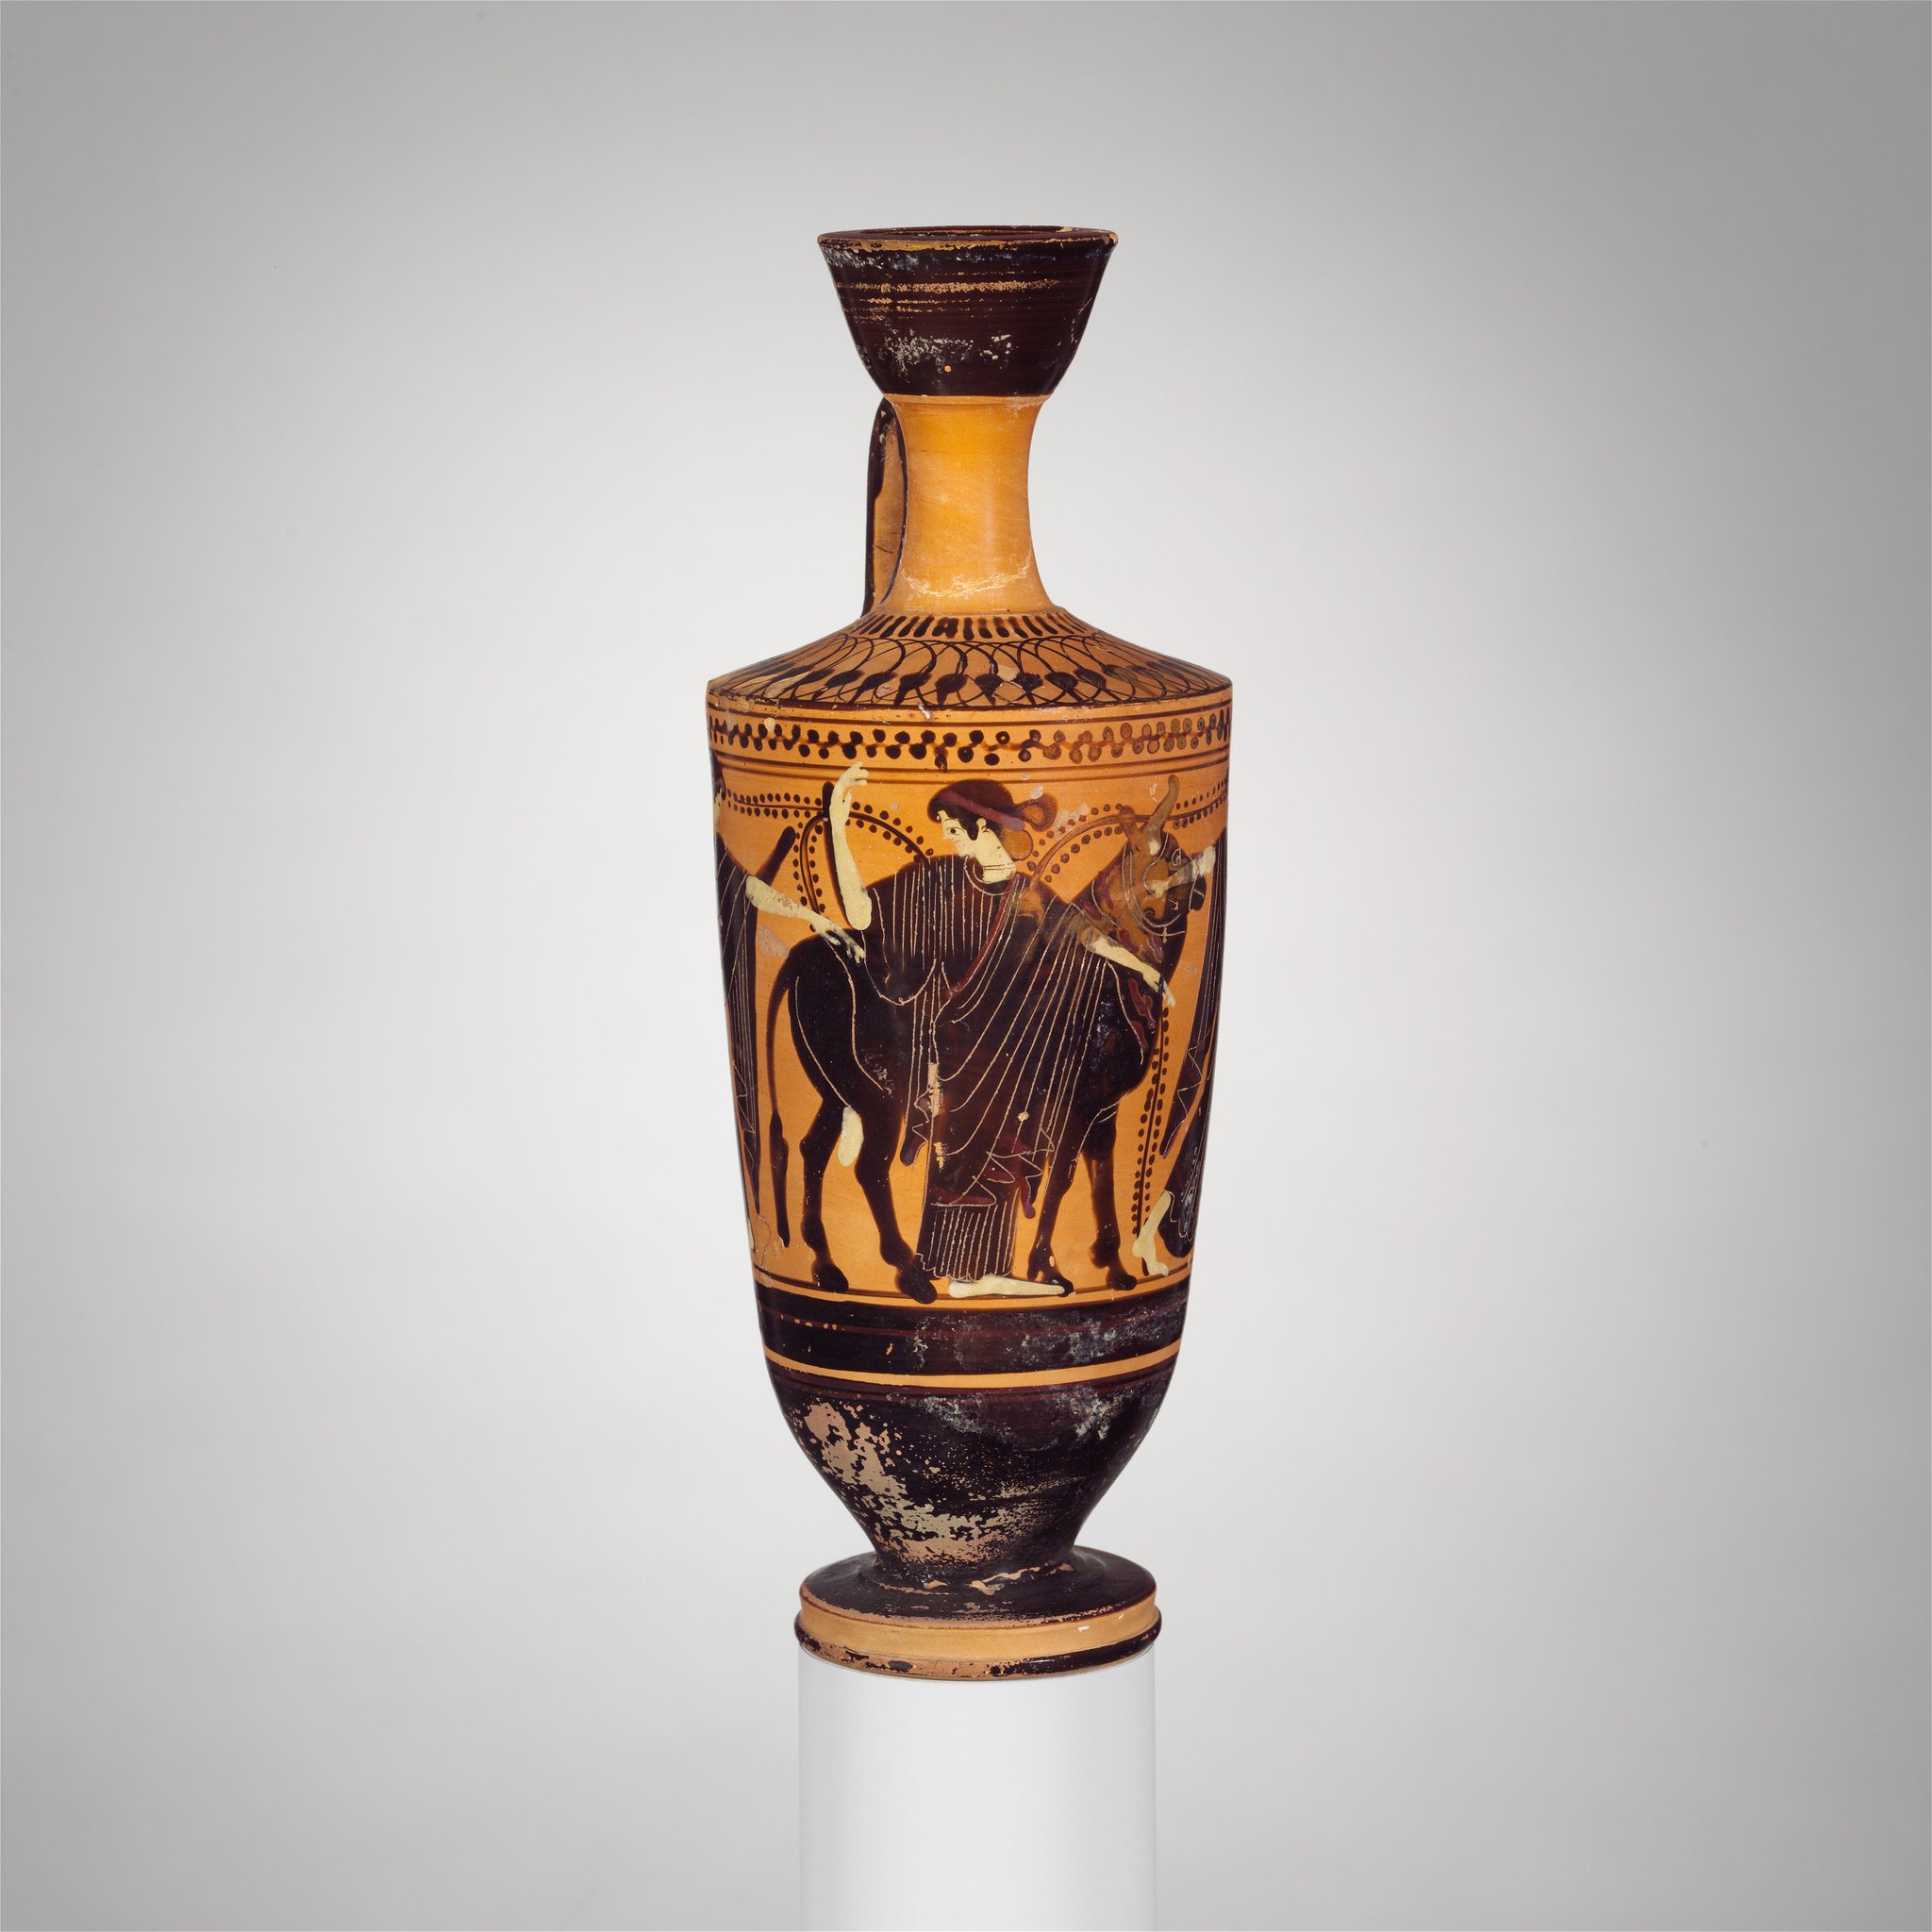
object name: lekythos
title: Terracotta lekythos (oil flask)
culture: greek, attic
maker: midway between the diosphos painter and the haimon painter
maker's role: artist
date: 500-476 BCE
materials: terracotta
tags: women,bulls